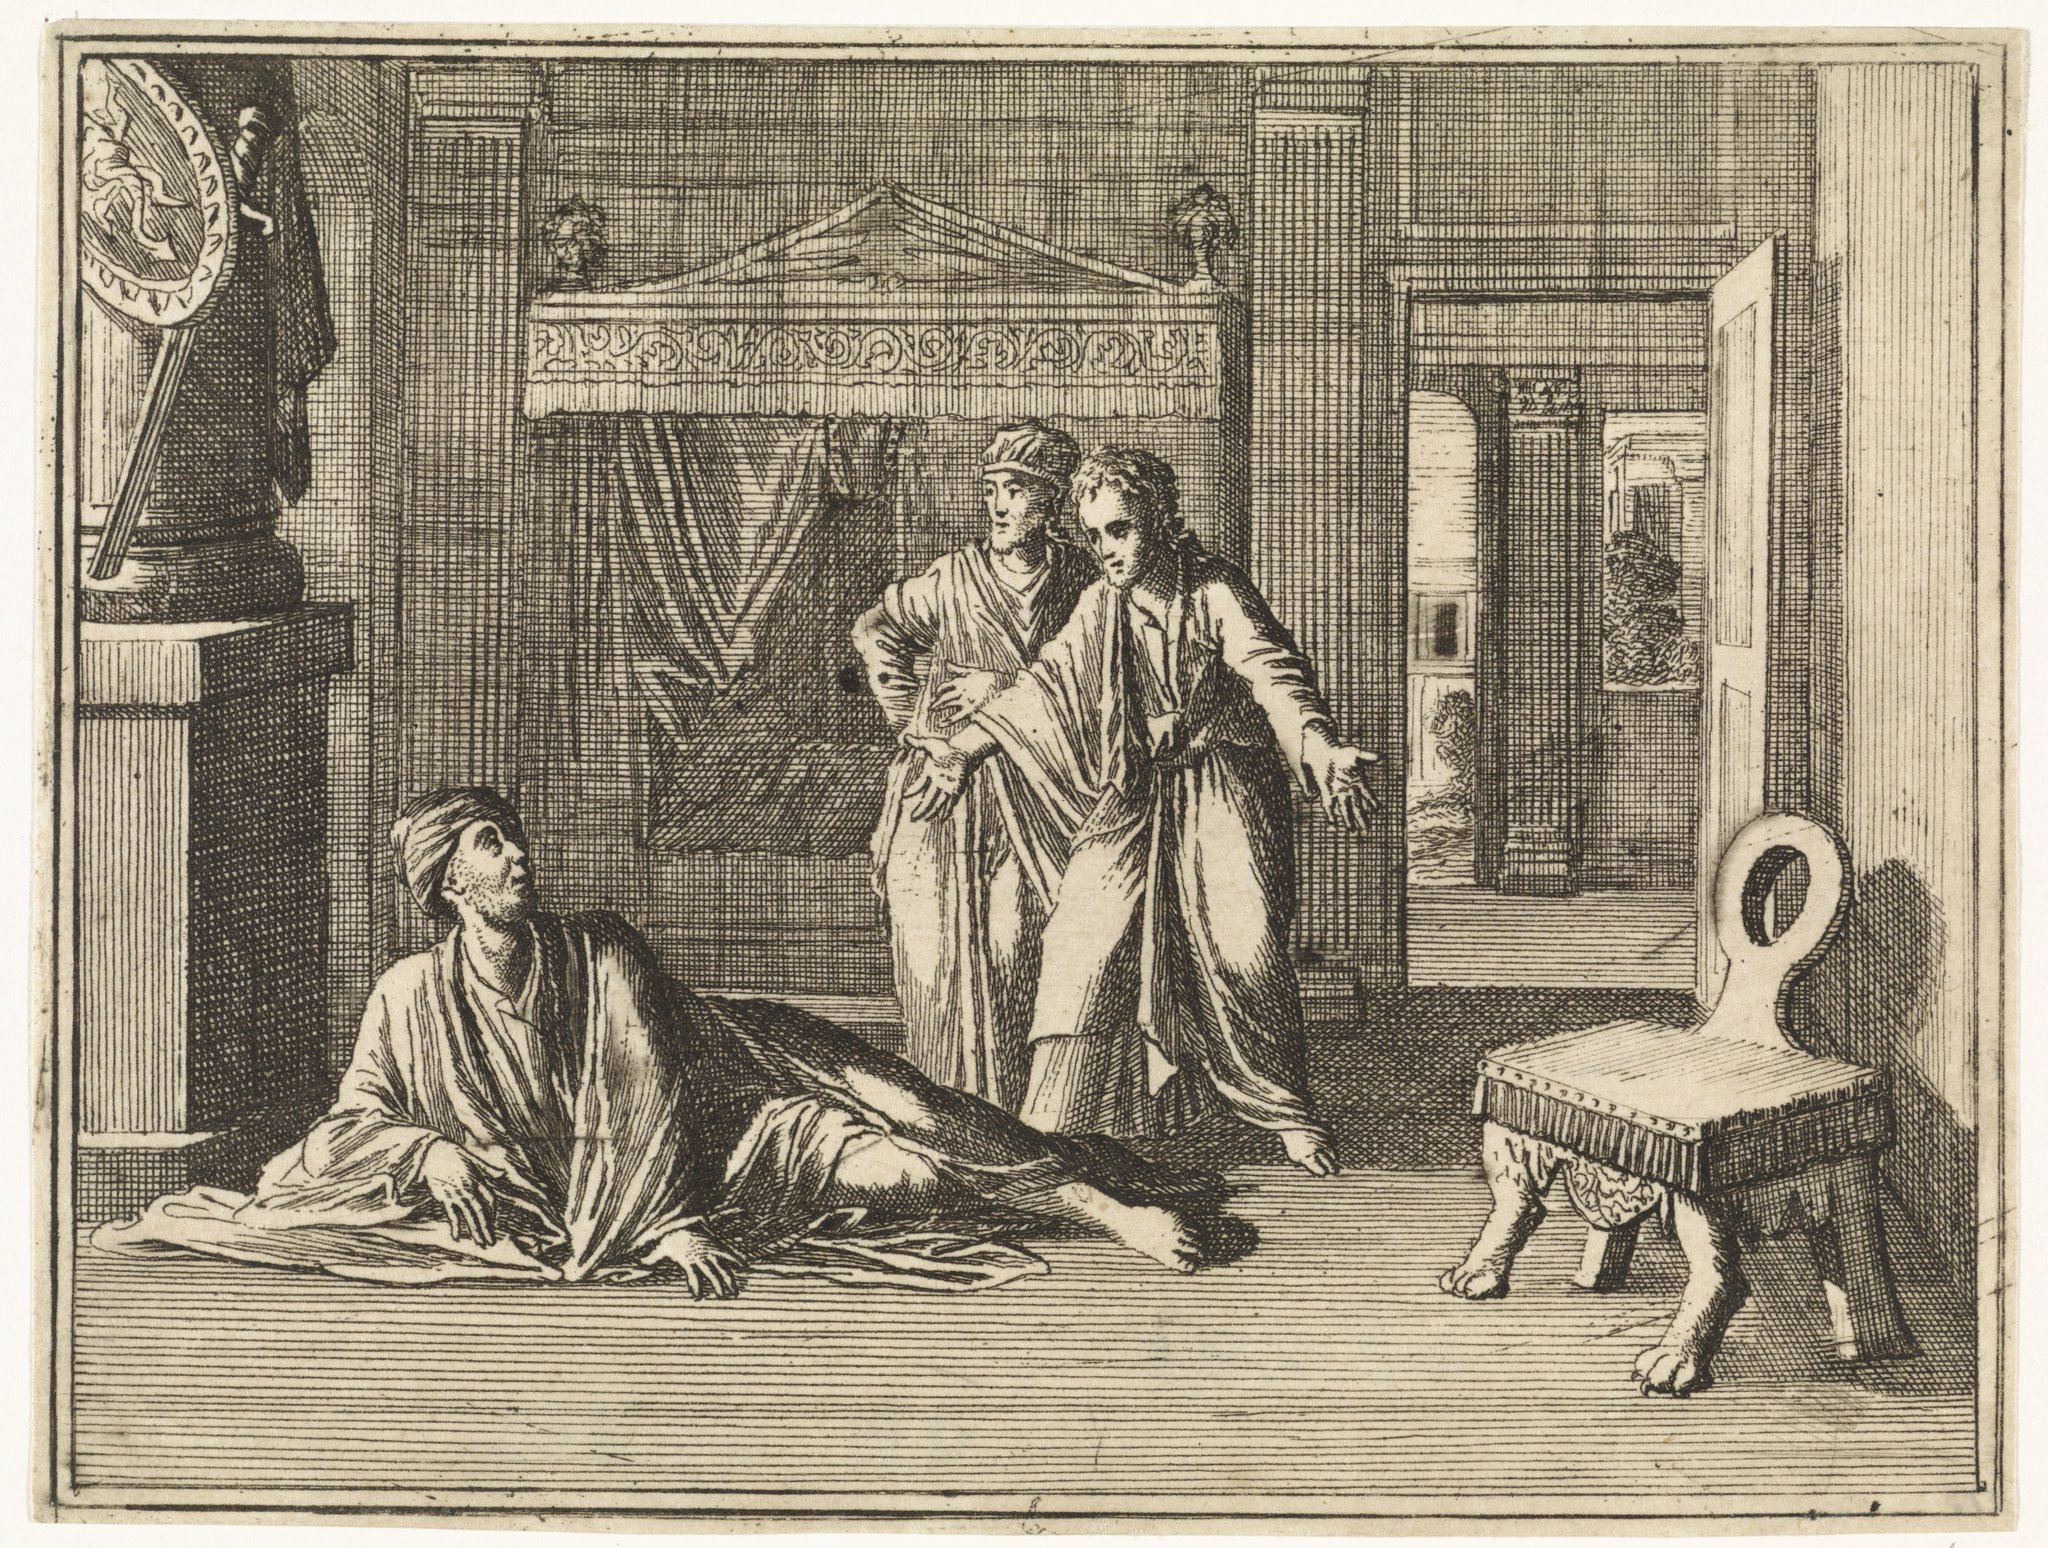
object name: print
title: David bidt voor het leven van het kind van Bathseba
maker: caspar luyken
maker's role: draughtsman, print maker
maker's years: 1672-1708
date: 1712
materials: paper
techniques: etching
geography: amsterdam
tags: david repentant; he lies on the ground praying and fasting for his child to recover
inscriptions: collector's mark: Lugt 2228, number: ‘113’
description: Illustratie uit: Luyken, Jan. De schriftuurlyke geschiedenissen en gelykenissen van het Oude en Nieuwe Verbond, 2 delen. Amsterdam: Wed. Pieter Arentsz II en Cornelis van der Sys, 1712, dl. I.